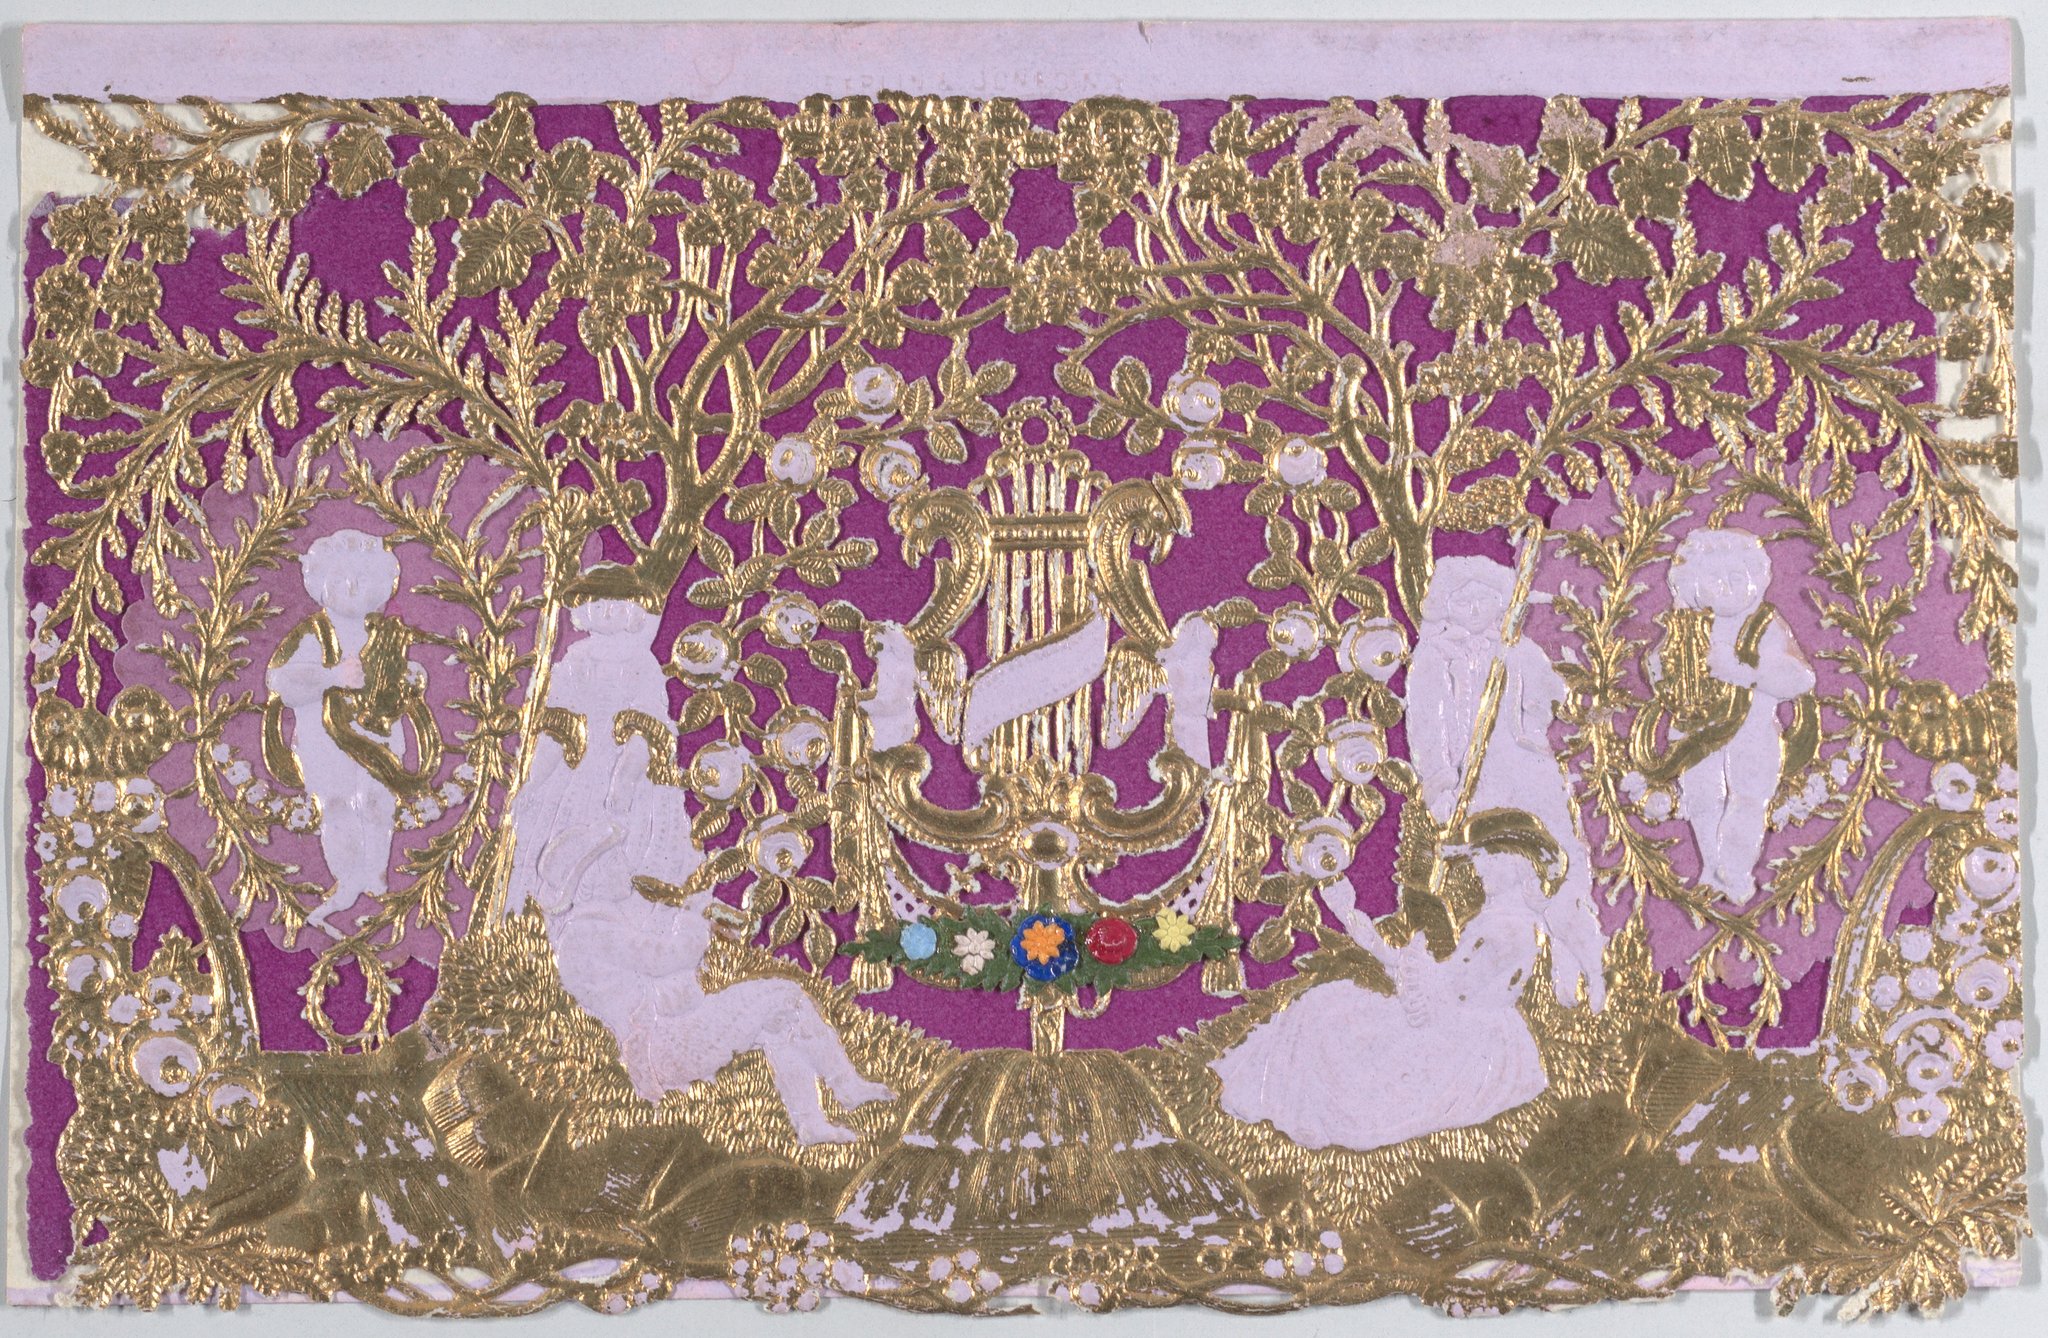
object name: valentine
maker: Anonymous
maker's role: artist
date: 1850-1870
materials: lace, paper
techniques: cutting, embossing, gilding, open work